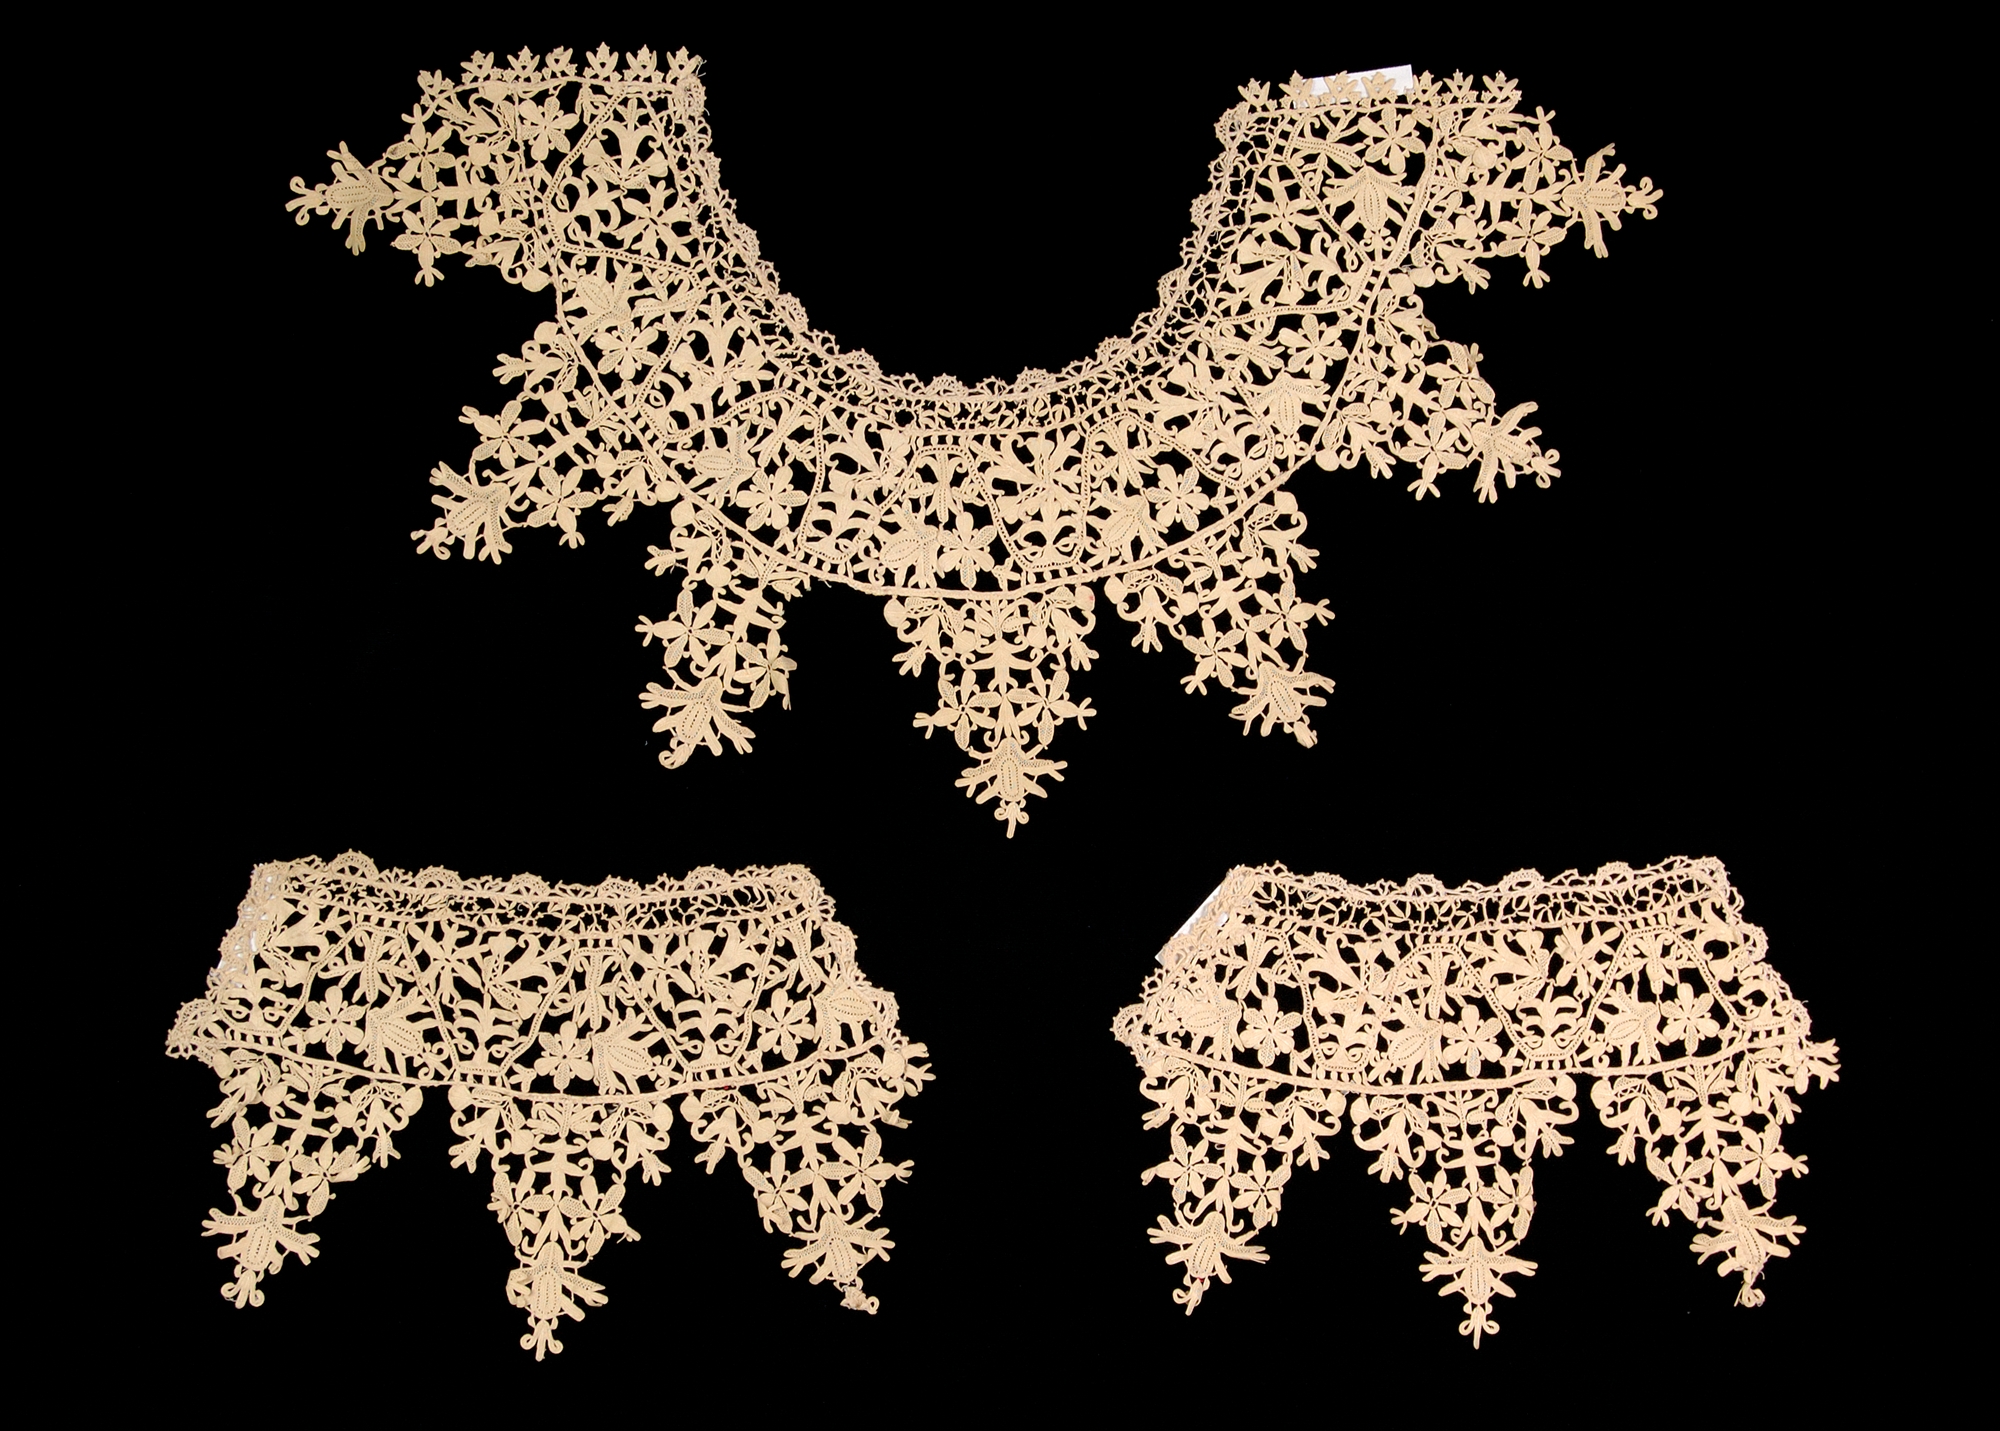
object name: accessory set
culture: american or european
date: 1876-1900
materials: linen